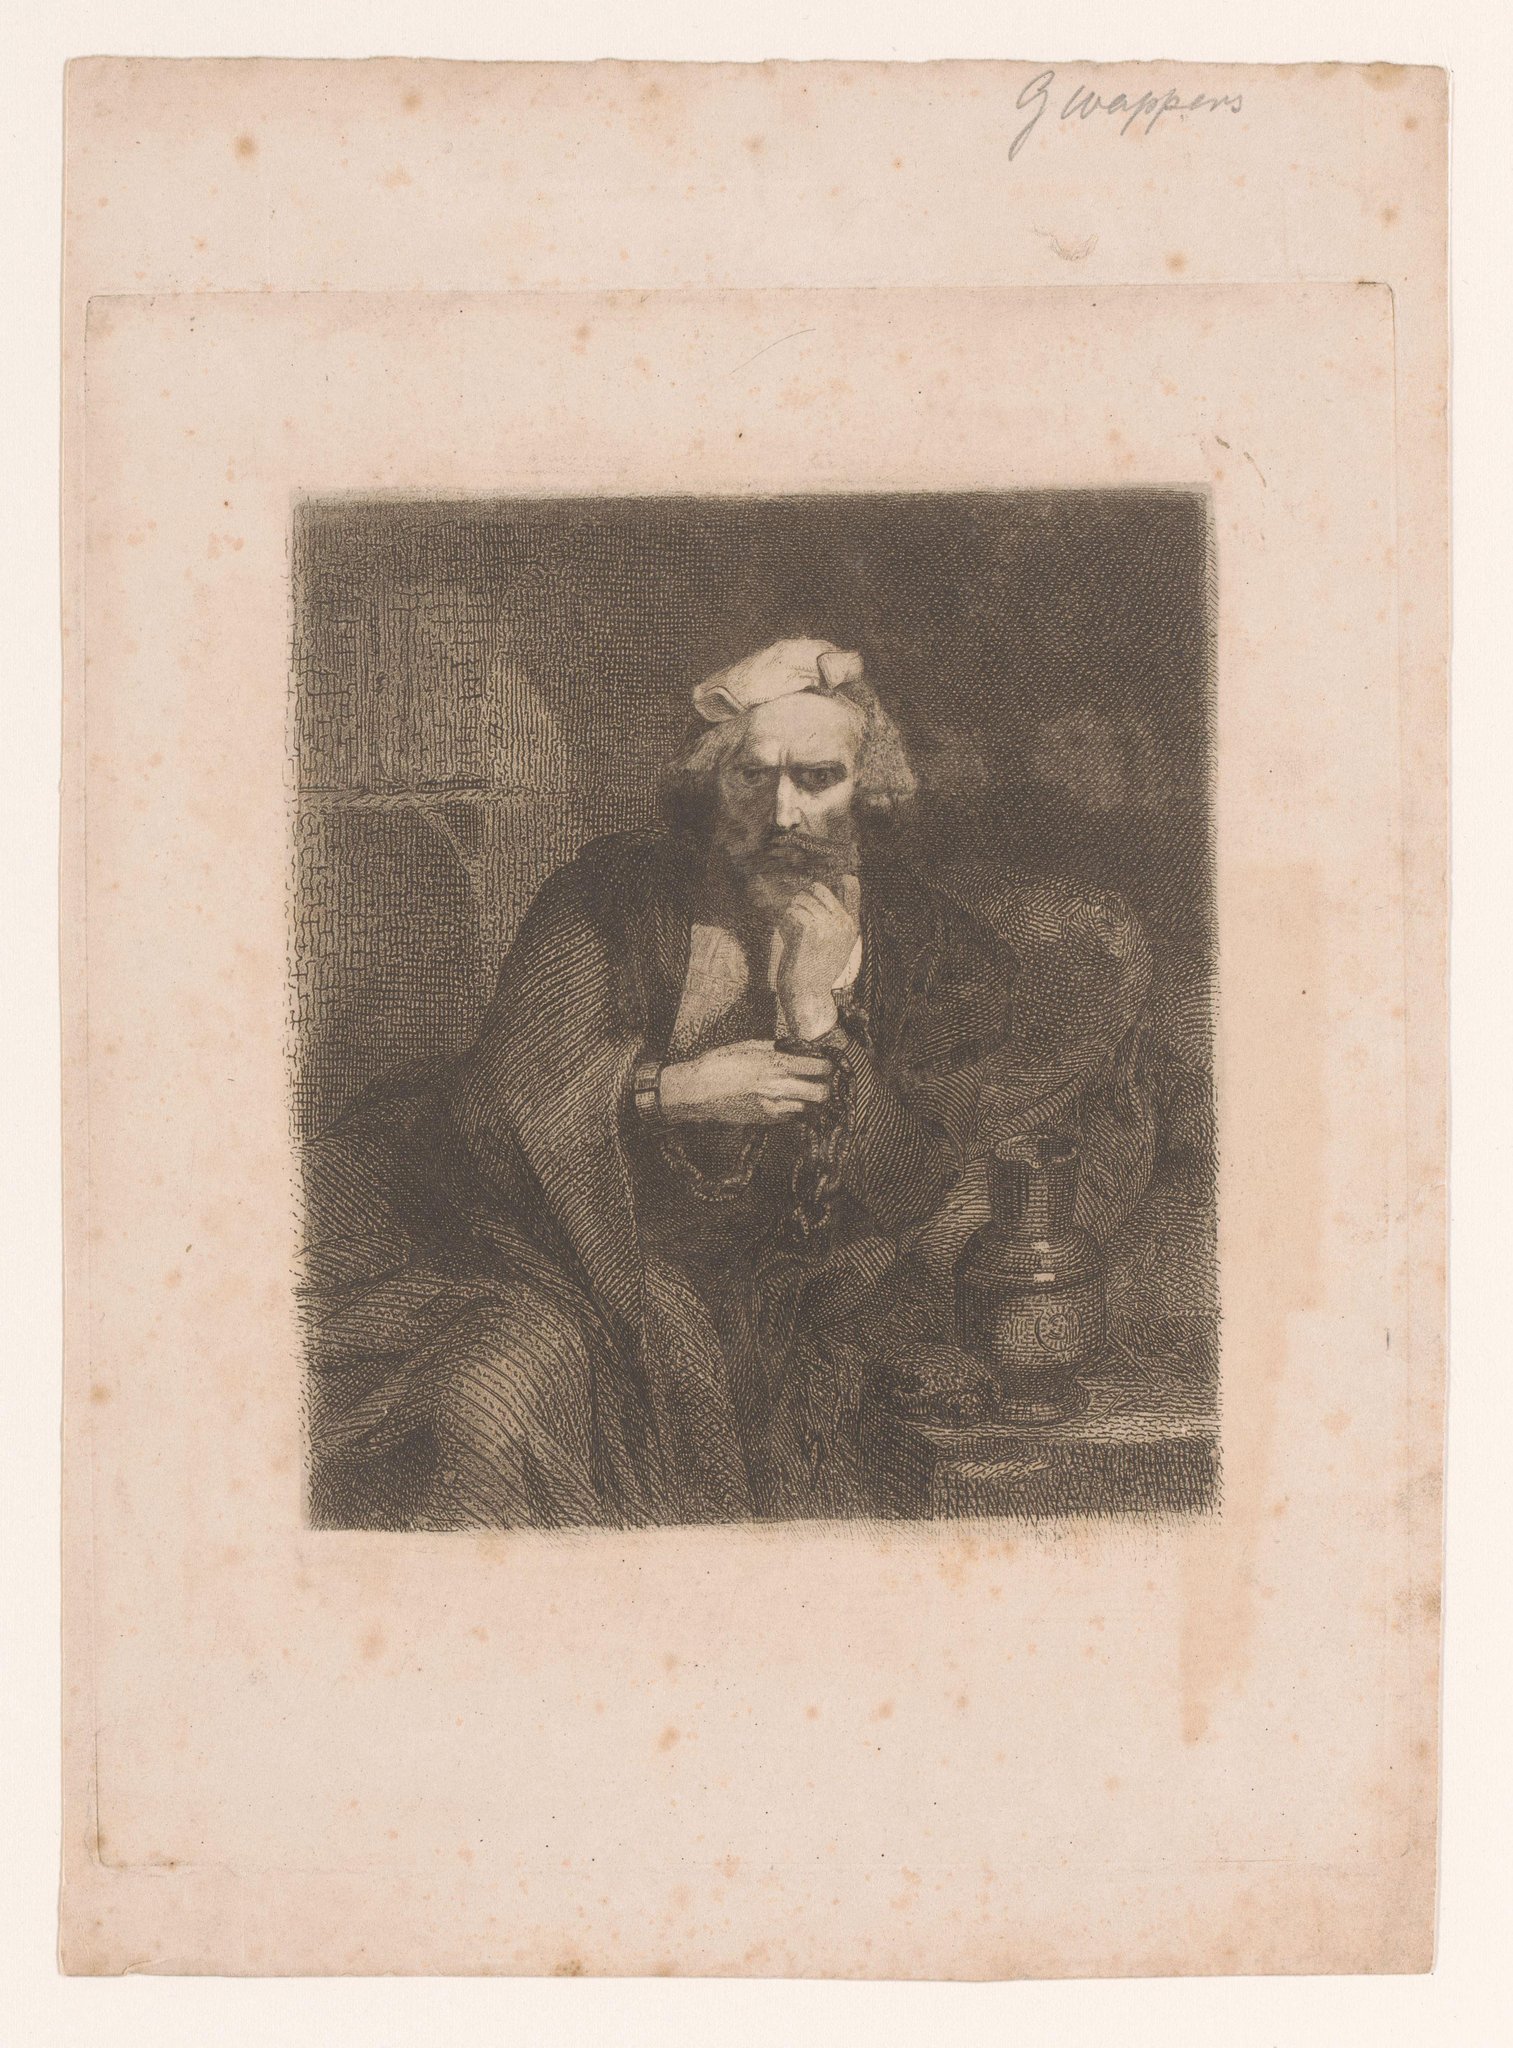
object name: print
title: Man met ketens om zijn handen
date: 1800-1874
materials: paper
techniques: aquatint, etching, retroussage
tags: adult man, prisoner; in fetters, beard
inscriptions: collector's mark: Lugt 2228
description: Op verso een vlak met dunne, zwarte lijnen dicht langs elkaar. Prent identiek aan RP-P-1913-3994 en RP-P-1913-4137 maar in de inventaris toegeschreven aan verschillende kunstenaars.